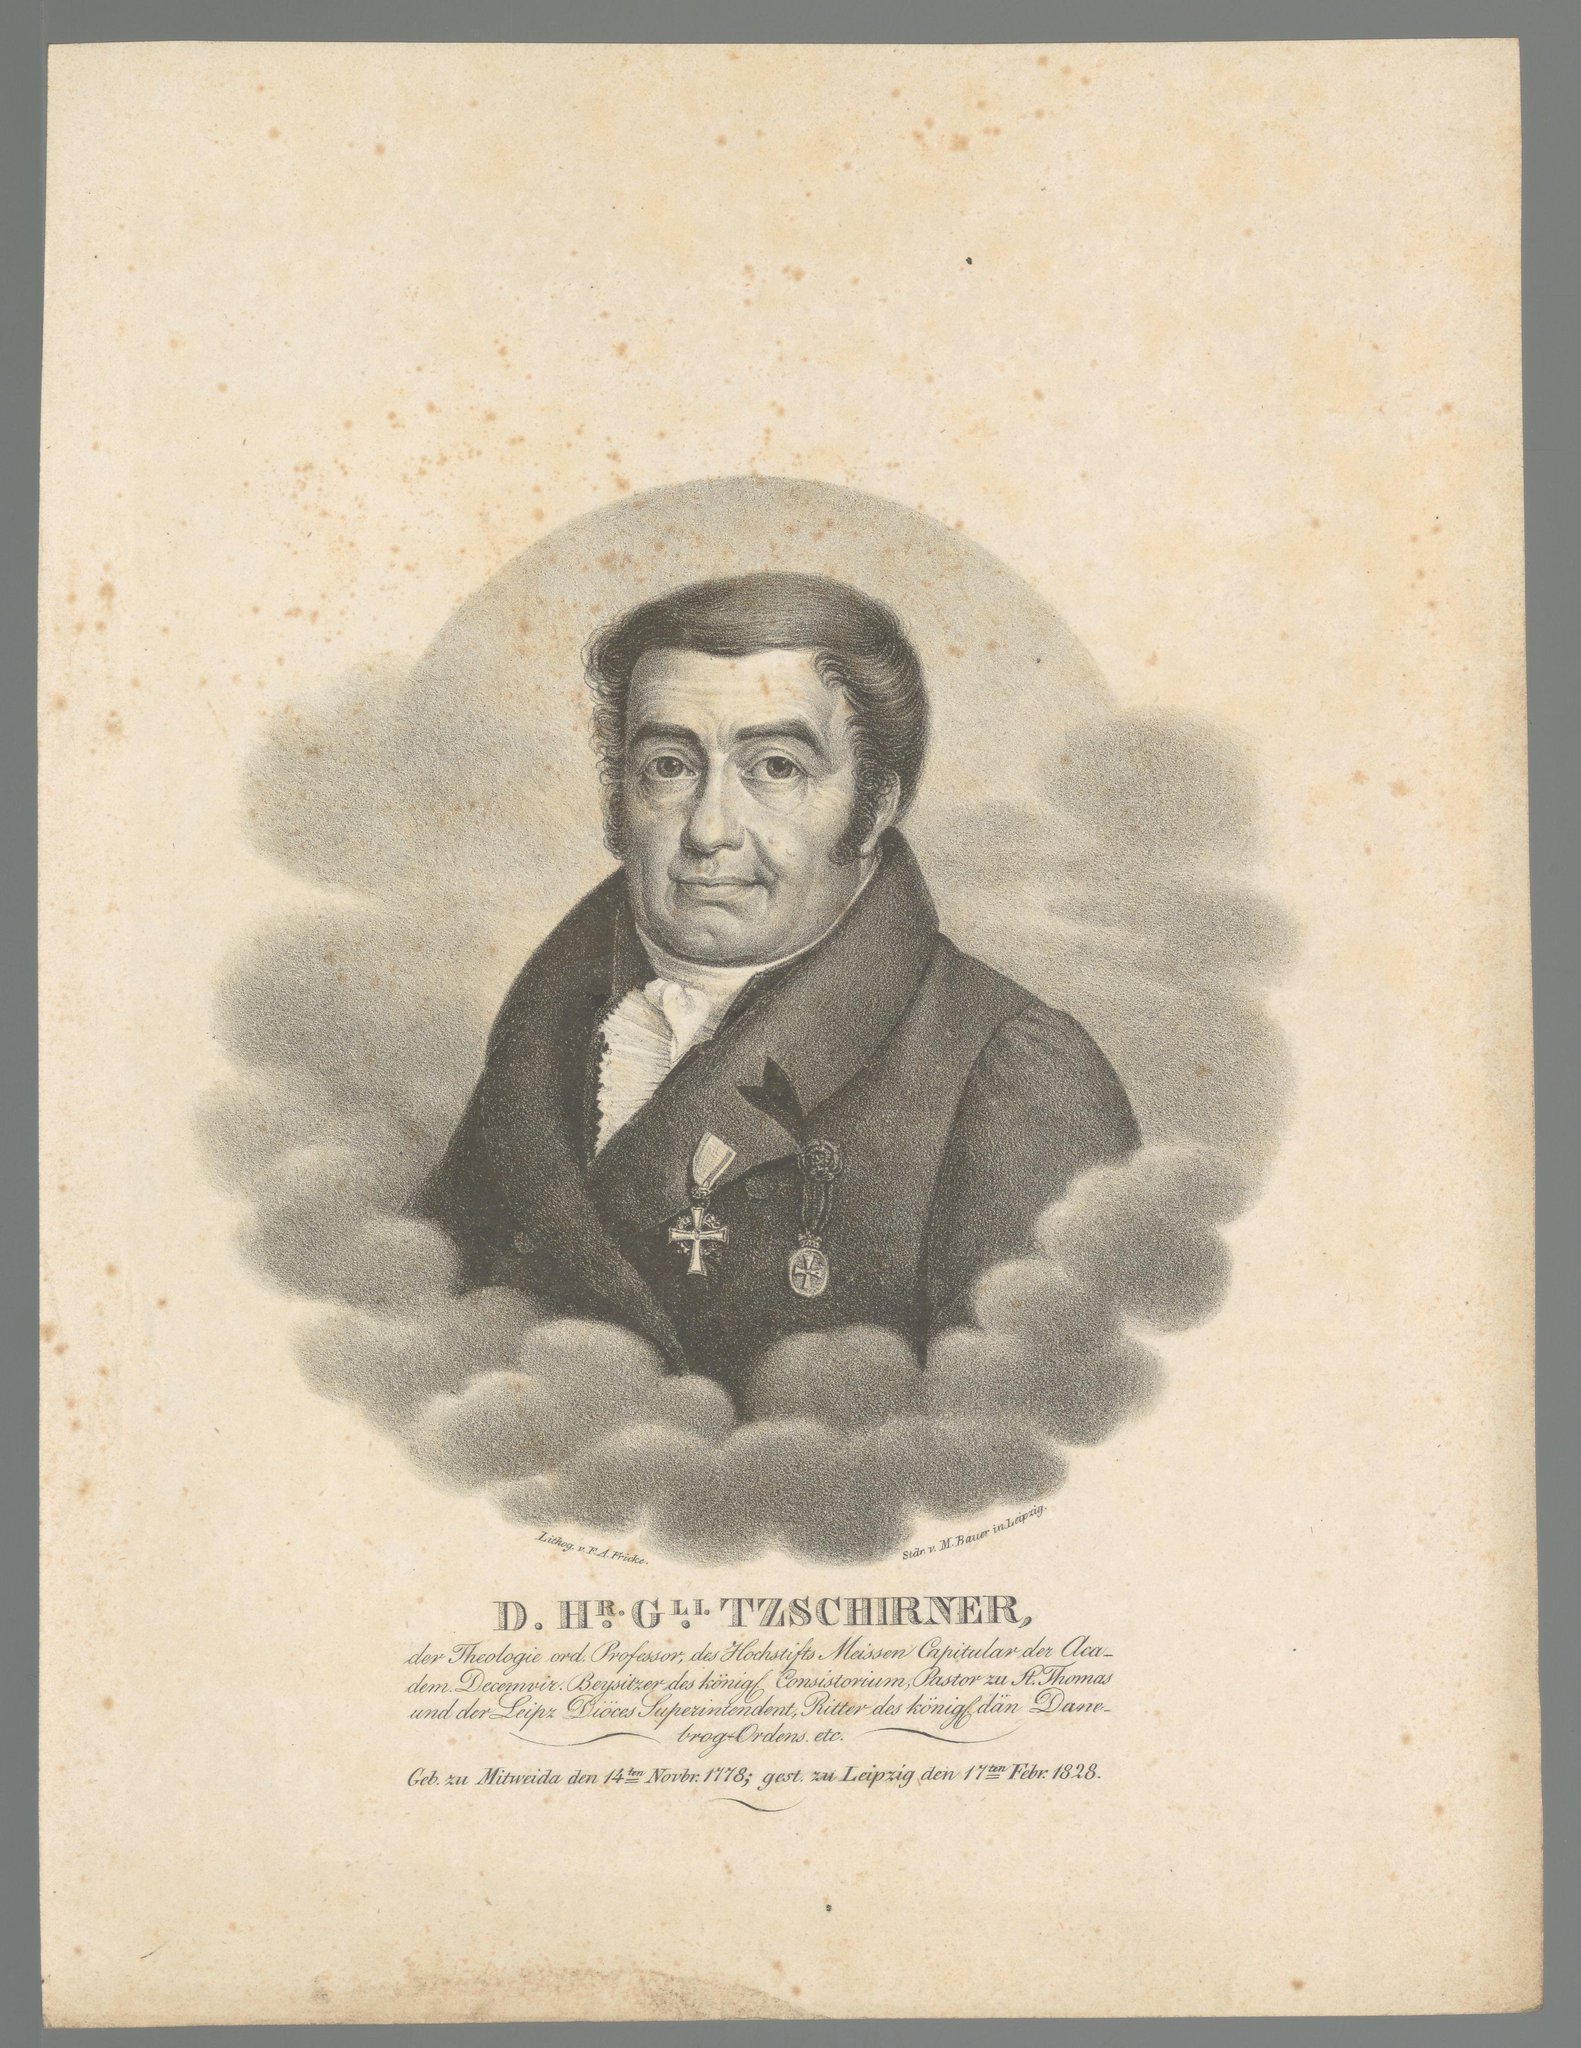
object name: print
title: Portret van Heinrich Gottlieb Tzschirner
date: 1828-1858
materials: paper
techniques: lithograph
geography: leipzig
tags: adult man, historical persons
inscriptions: collector's mark: Lugt 2228